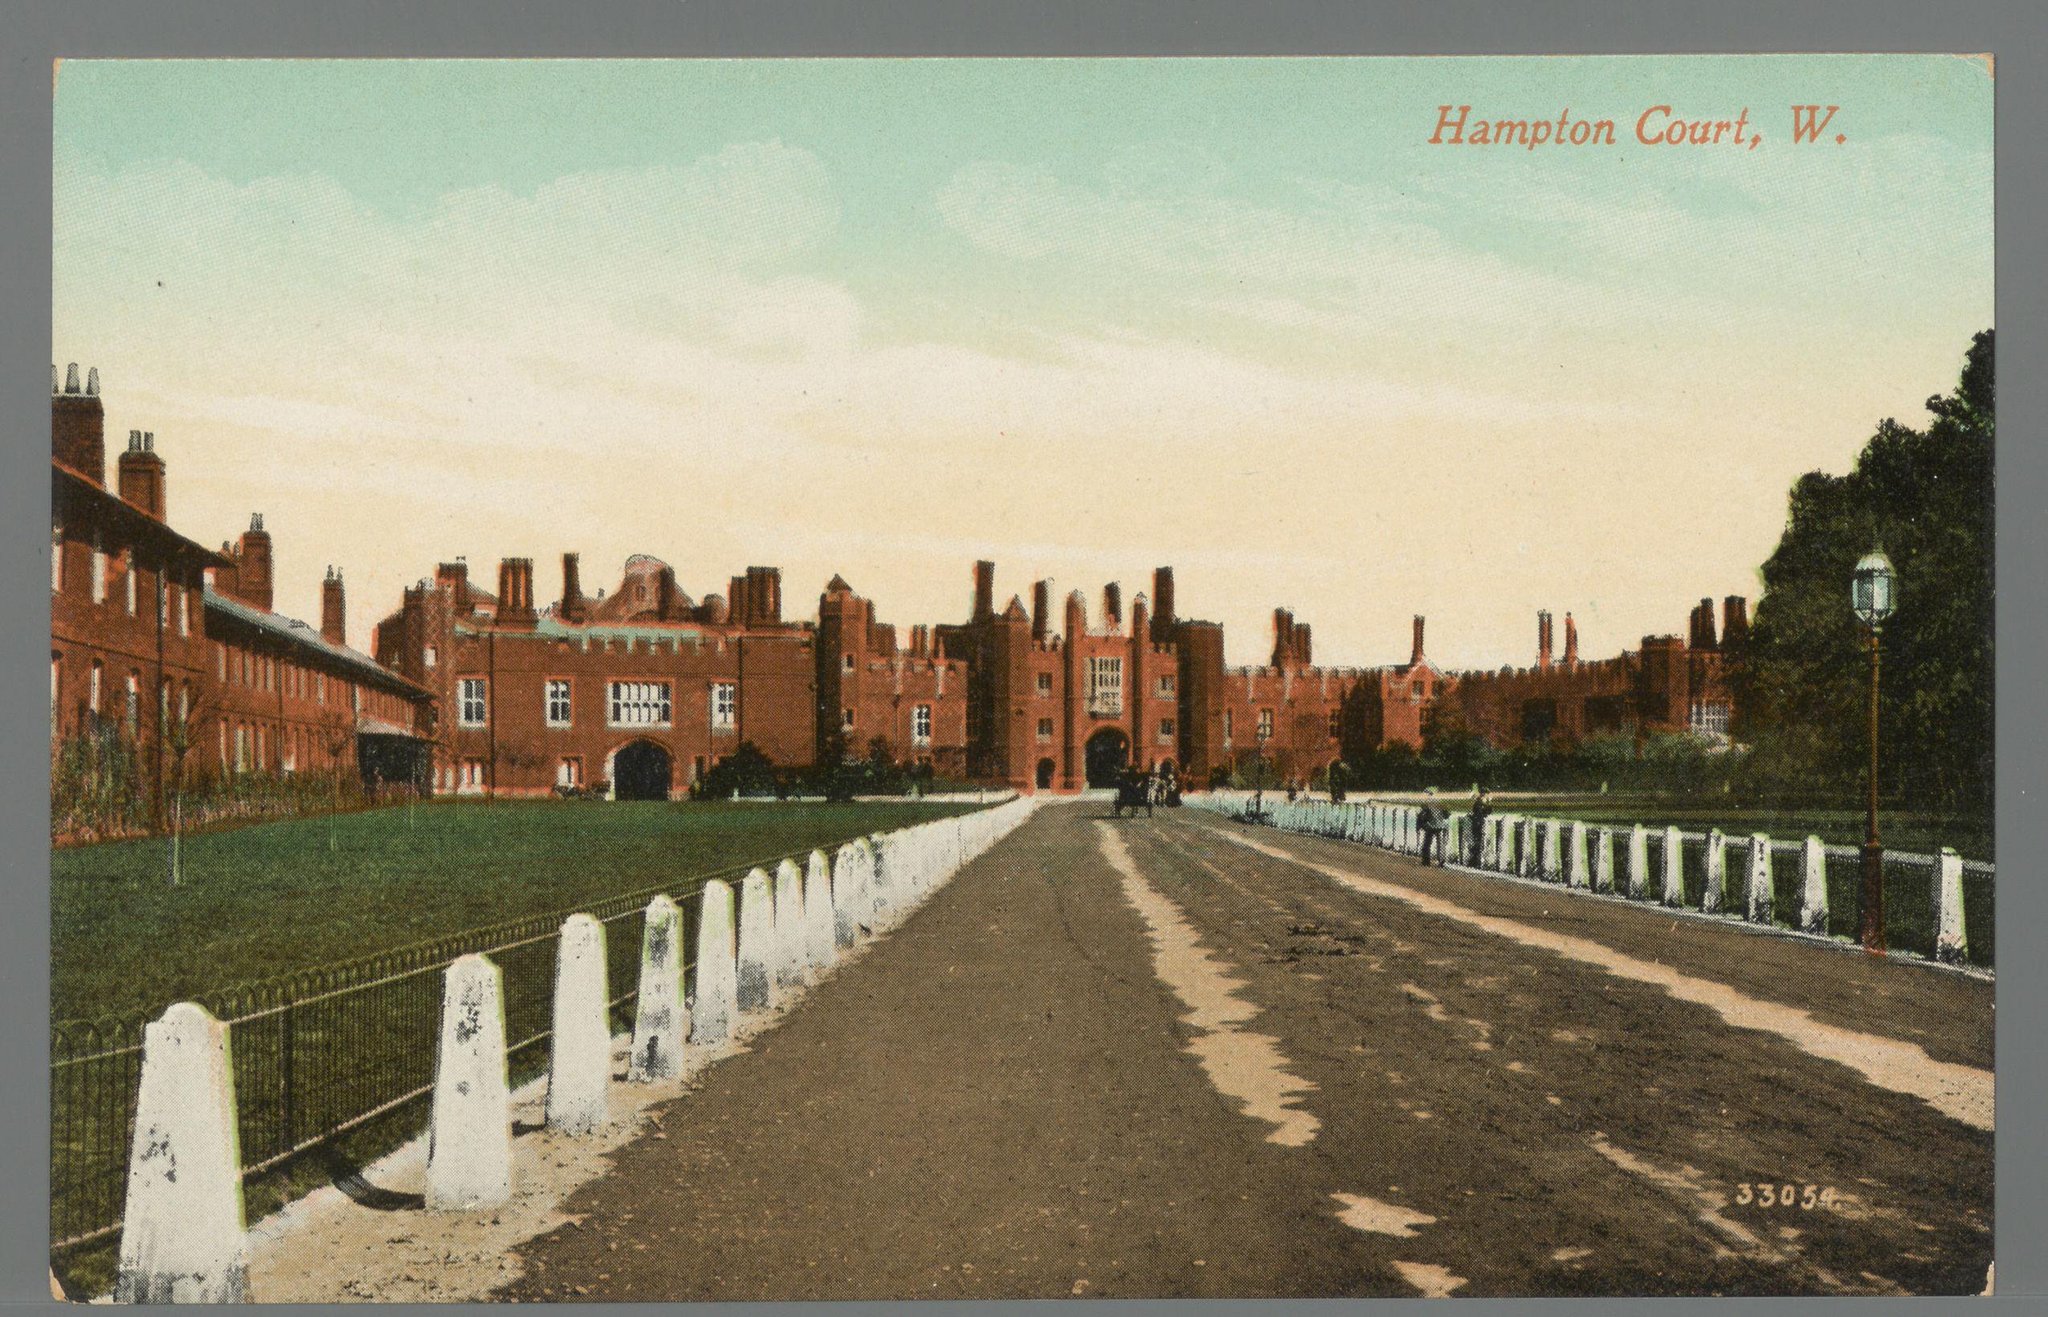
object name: ansichtkaart, prentbriefkaart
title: Valentine's Series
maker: Anonymous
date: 1902-1930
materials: cardboard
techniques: lithograph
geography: hampton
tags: palace